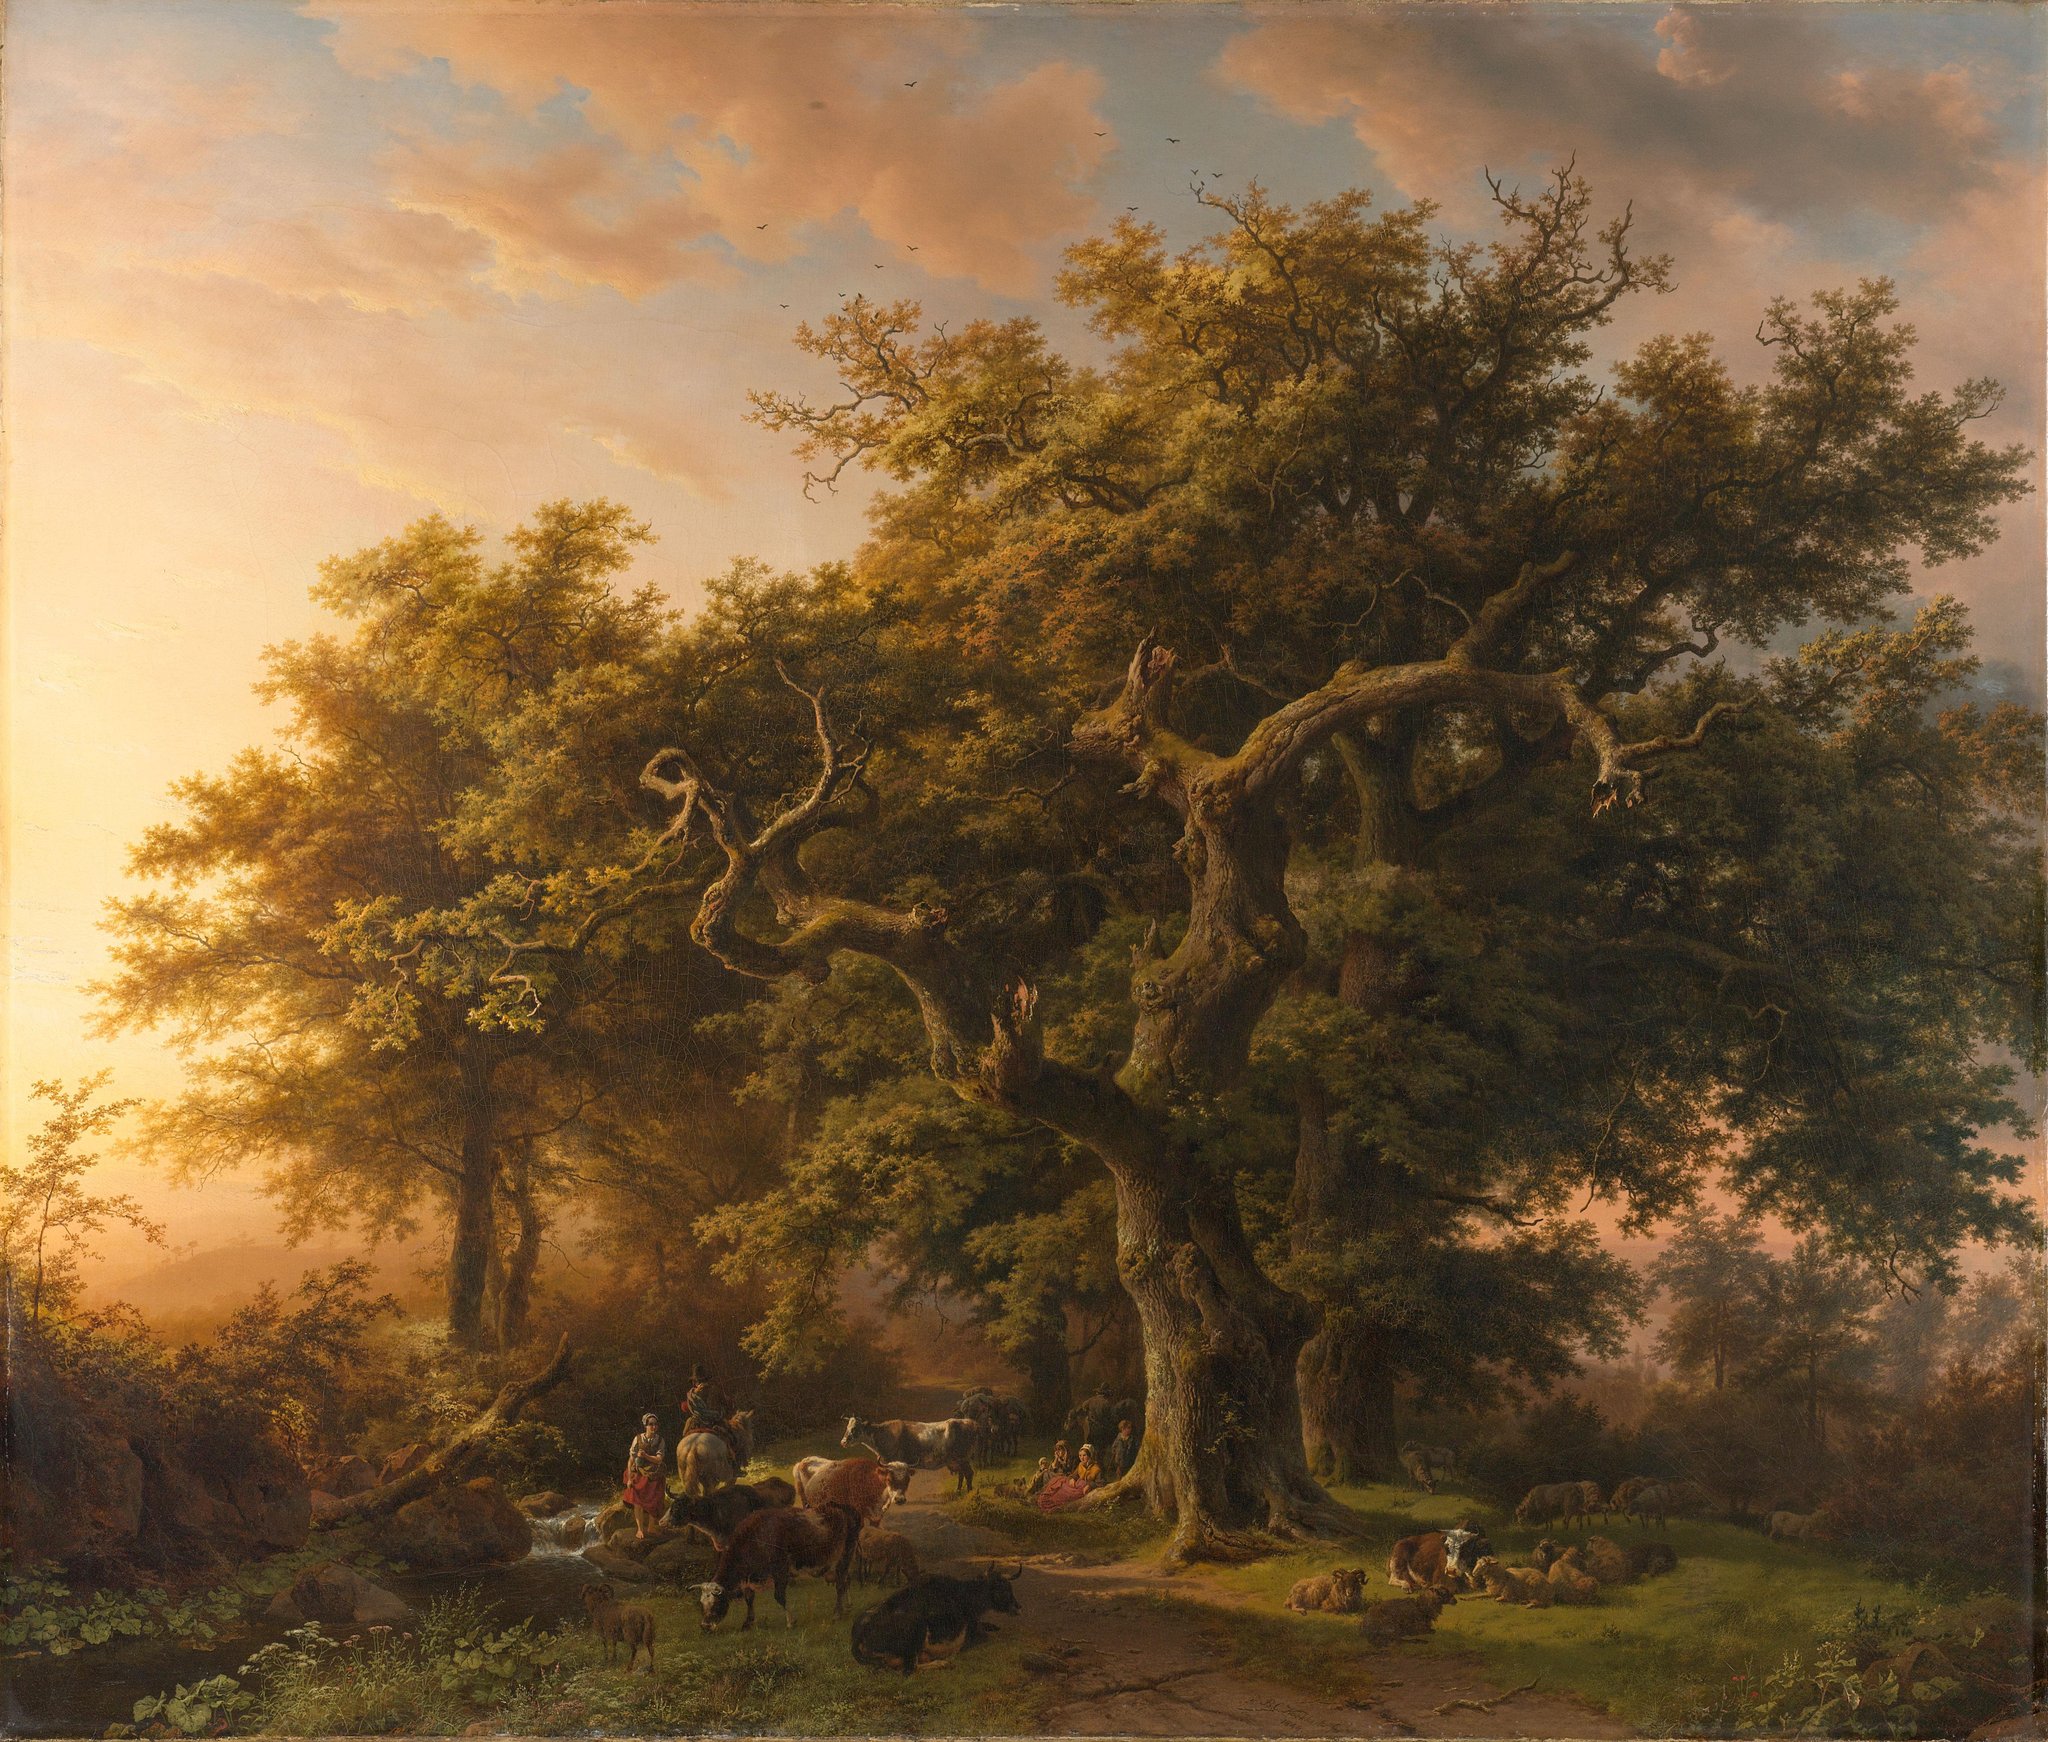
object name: painting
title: View in the Woods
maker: barend cornelis koekkoek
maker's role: draughtsman, painter, print maker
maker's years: 1803-1862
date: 1848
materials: canvas, oil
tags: herding, herdsman, herdswoman, shepherd, shepherdess, cowherd, etc., forest, wood, herd, flock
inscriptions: signature and date: ‘B.C. Koekkoek ft 1848’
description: Of all Dutch landscape painters, Koekkoek is perhaps the most Romantic. He specialized in splendid panora-mas of the valley of the Rhine and forest scenes with majestic trees, which at the time were called ‘Wodan’s Oaks’ (Wodan being the Dutch name for Odin, the major god in Norse mythology). In 1834 Koekkoek settled in Cleves in Germany, over the border from Nijmegen. He found German scenery, with its hills and the Rhine, more romantic than the Dutch landscape.